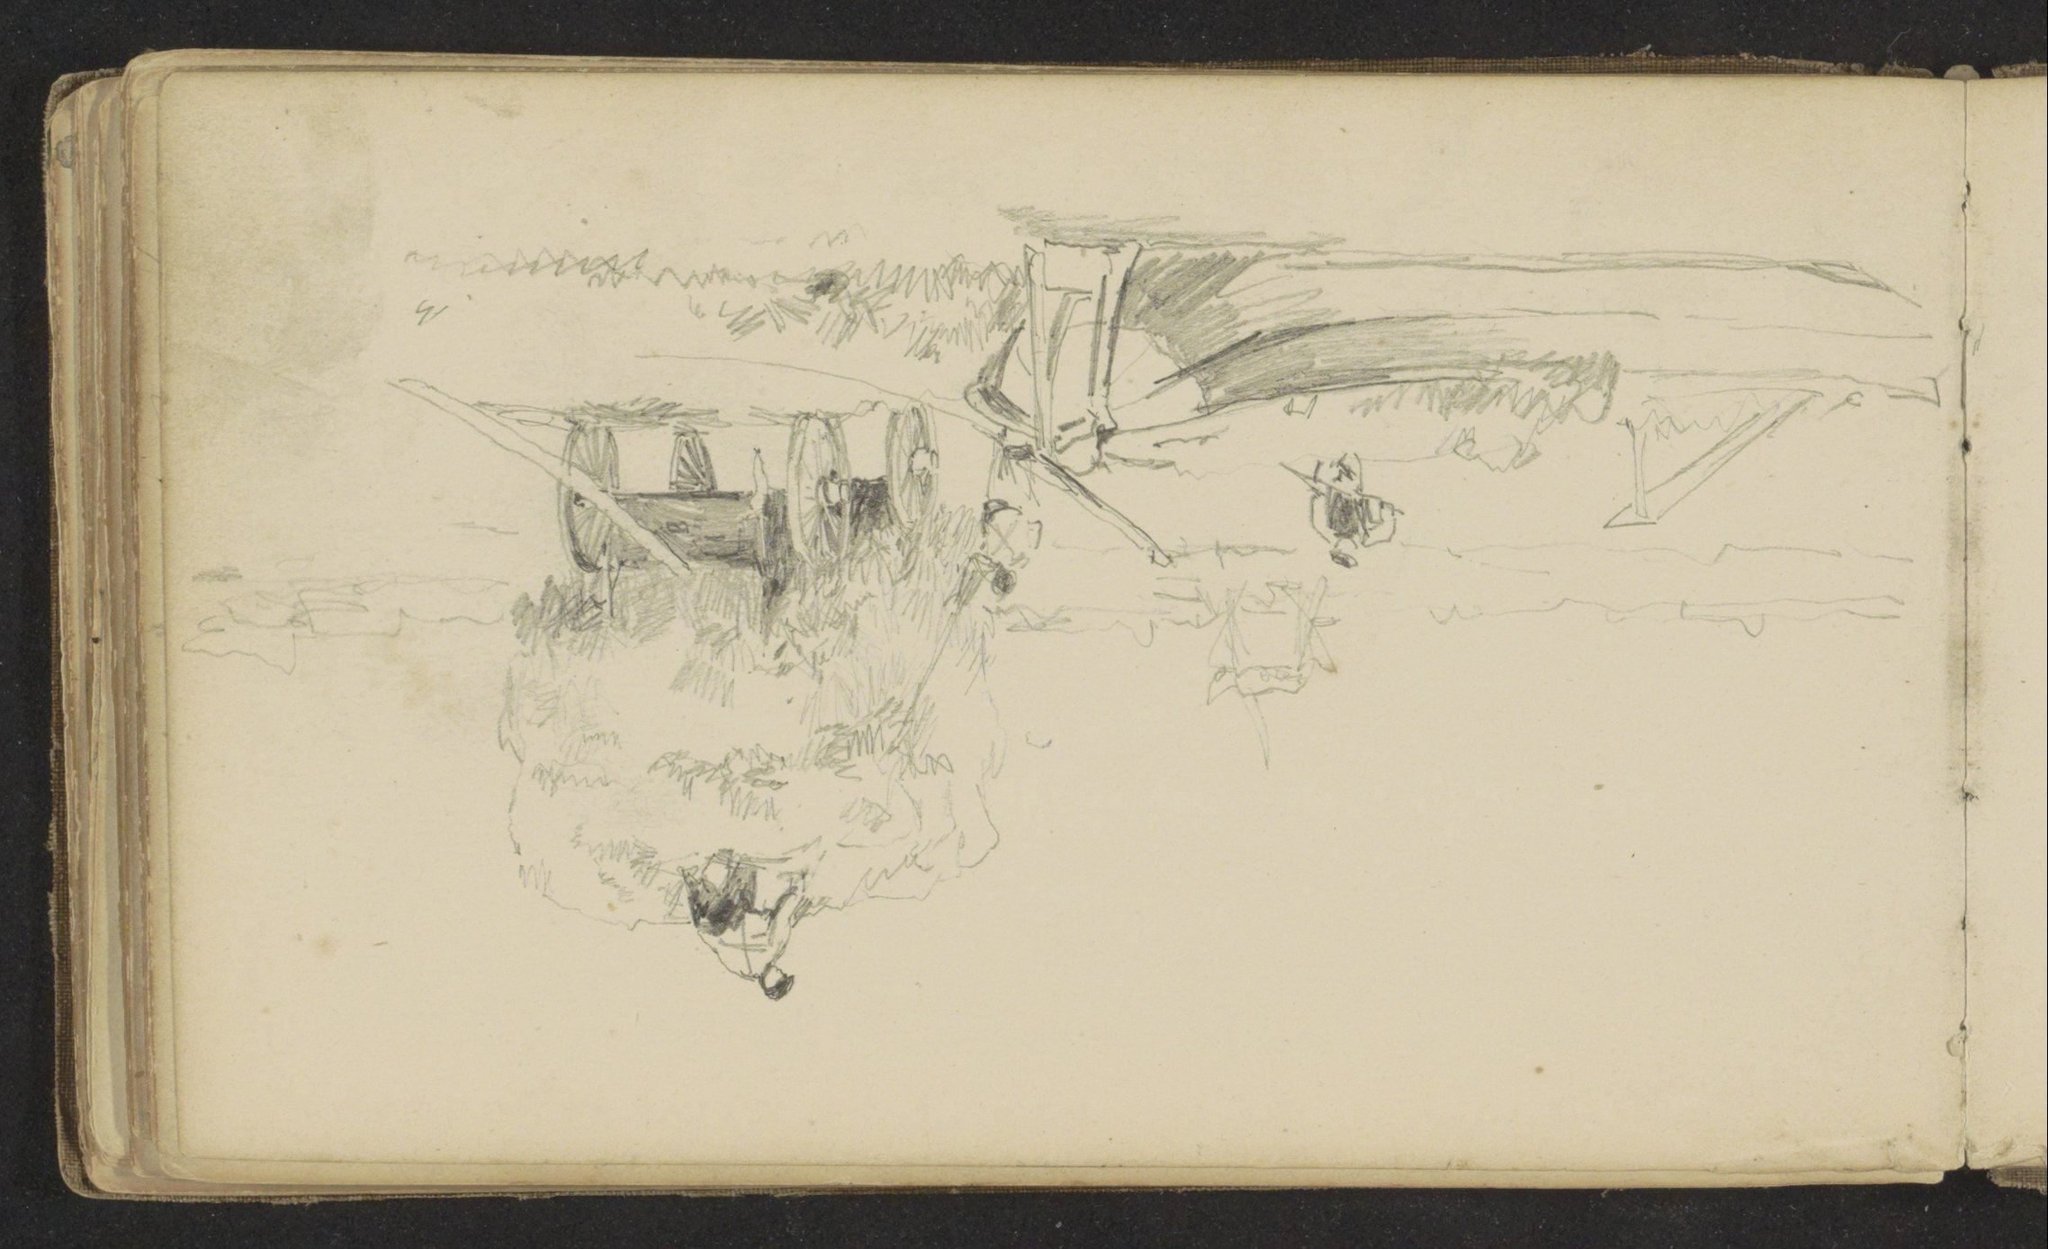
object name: sketchbook leaf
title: Landschap met boeren en een hooiwagen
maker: johan hendrik weissenbruch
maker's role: draughtsman, painter, print maker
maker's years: 1824-1903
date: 1834-1903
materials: paper, pencil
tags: hay-wagon, landscapes with waters, waterscapes, seascapes (in the temperate zone) (+ landscape with figures, staffage)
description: De drie boeren werken op en naast de hooiwagen. Op de voorgrond ligt een schuit aangemeerd aan een waterkant. Op de achtergrond een molen. Blad 40 verso uit een schetsboek met 43 bladen.